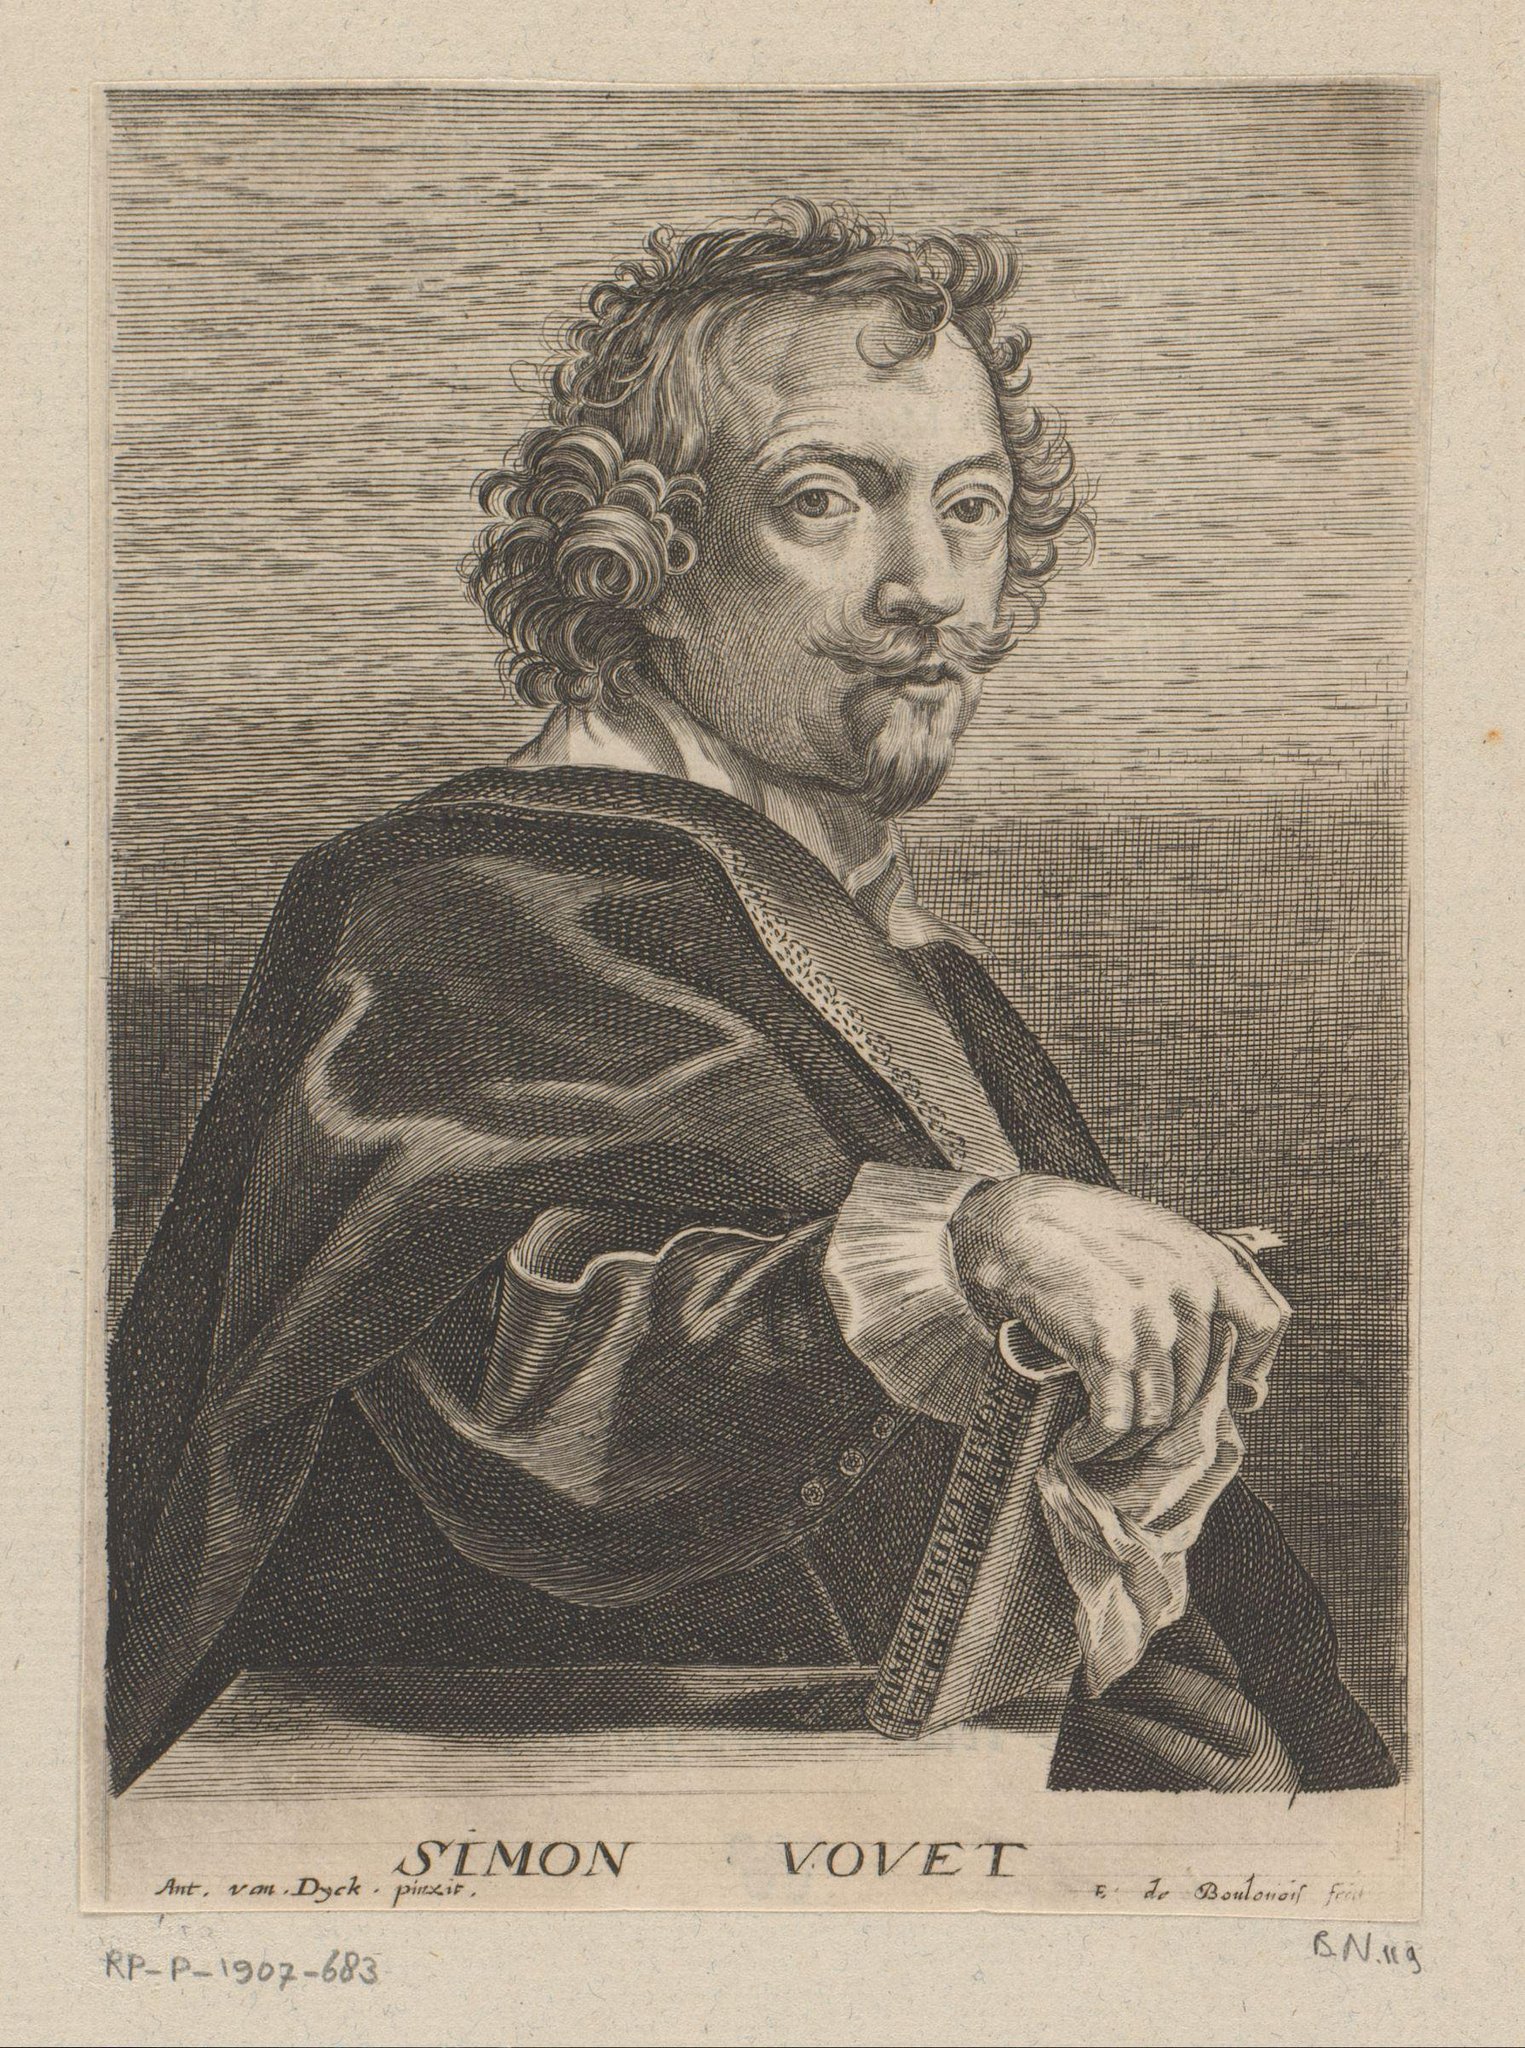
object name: book illustration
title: Portret van Simon Vouet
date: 1682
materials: paper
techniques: engraving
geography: brussels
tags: draughtsman, simon vouet, historical persons, portrait, self-portrait of artist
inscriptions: collector's mark: Lugt 2228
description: Prent uit: Bullert, Isaac. Académie des Sciences et Arts contenant les vies et éloges his. des hommes illustres qui ont excellé en ces professions depuis environ quatre siècles. Brussel: Foppens, François, 1682. Het boek werd in 1682 eveneens in Amsterdam uitgegeven door de erfgenamen van Daniel Elzevier. Deze portretten dienen ter illustratie van de biografie van een kunstenaar of geleerde. De meeste portretten werden door Nicolas de Larmessin vervaardigd (162), 93 door De Boulonois en een derde door ongeïdentificeerde prentmakers. Dit betreft een illustratie op p. 490, deel II.